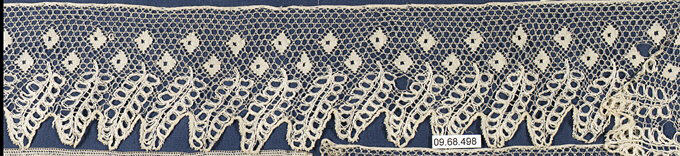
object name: piece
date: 1801-1900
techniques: lace